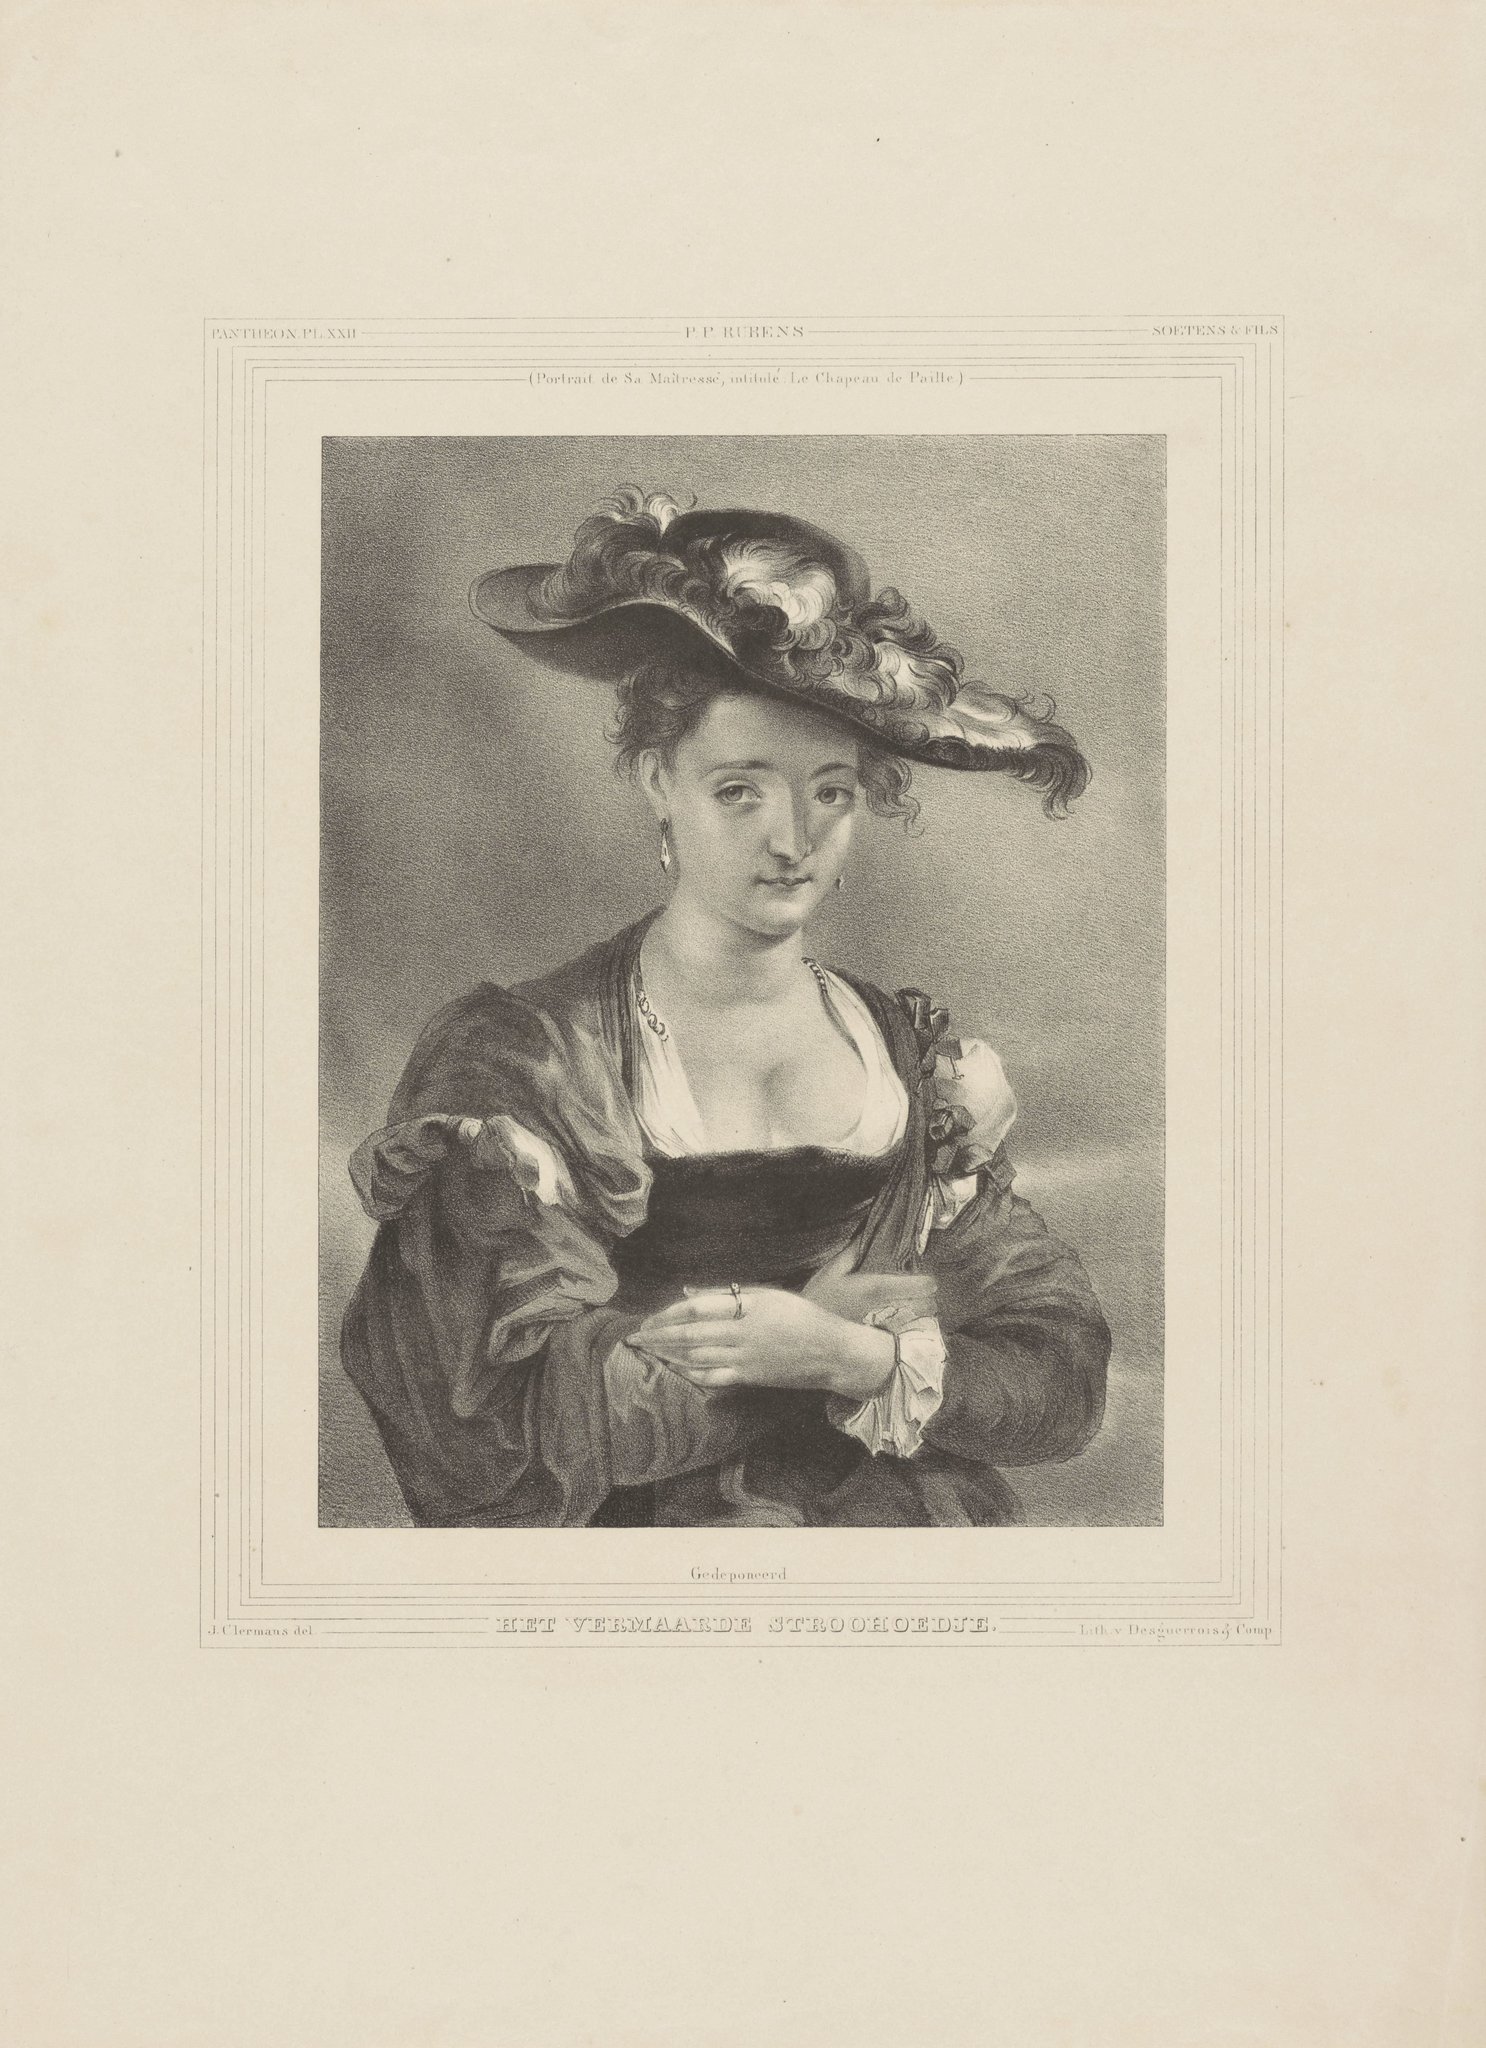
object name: print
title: Het vermaarde stroohoedje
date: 1837-1840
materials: paper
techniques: lithograph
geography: paris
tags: head-gear: hat, historical persons (+ half-length portrait), arms crossed over the breast, ear-rings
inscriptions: collector's mark: Lugt 2228, : ‘Gedeponeerd’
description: De dame heeft haar armen gekruist voor haar buik. Ze draagt een jurk met linten aan de mouwen, een hoed met veren, een ring en oorbellen. Naar een schilderij van Peter Paul Rubens uit 1625 in de National Gallery Londen. Boven de afbeelding: '(Portrait de Sa Maîtresse, institulé Le Chapeau de Paille)'. Linksboven: 'Pantheon. Pl. XXII'.